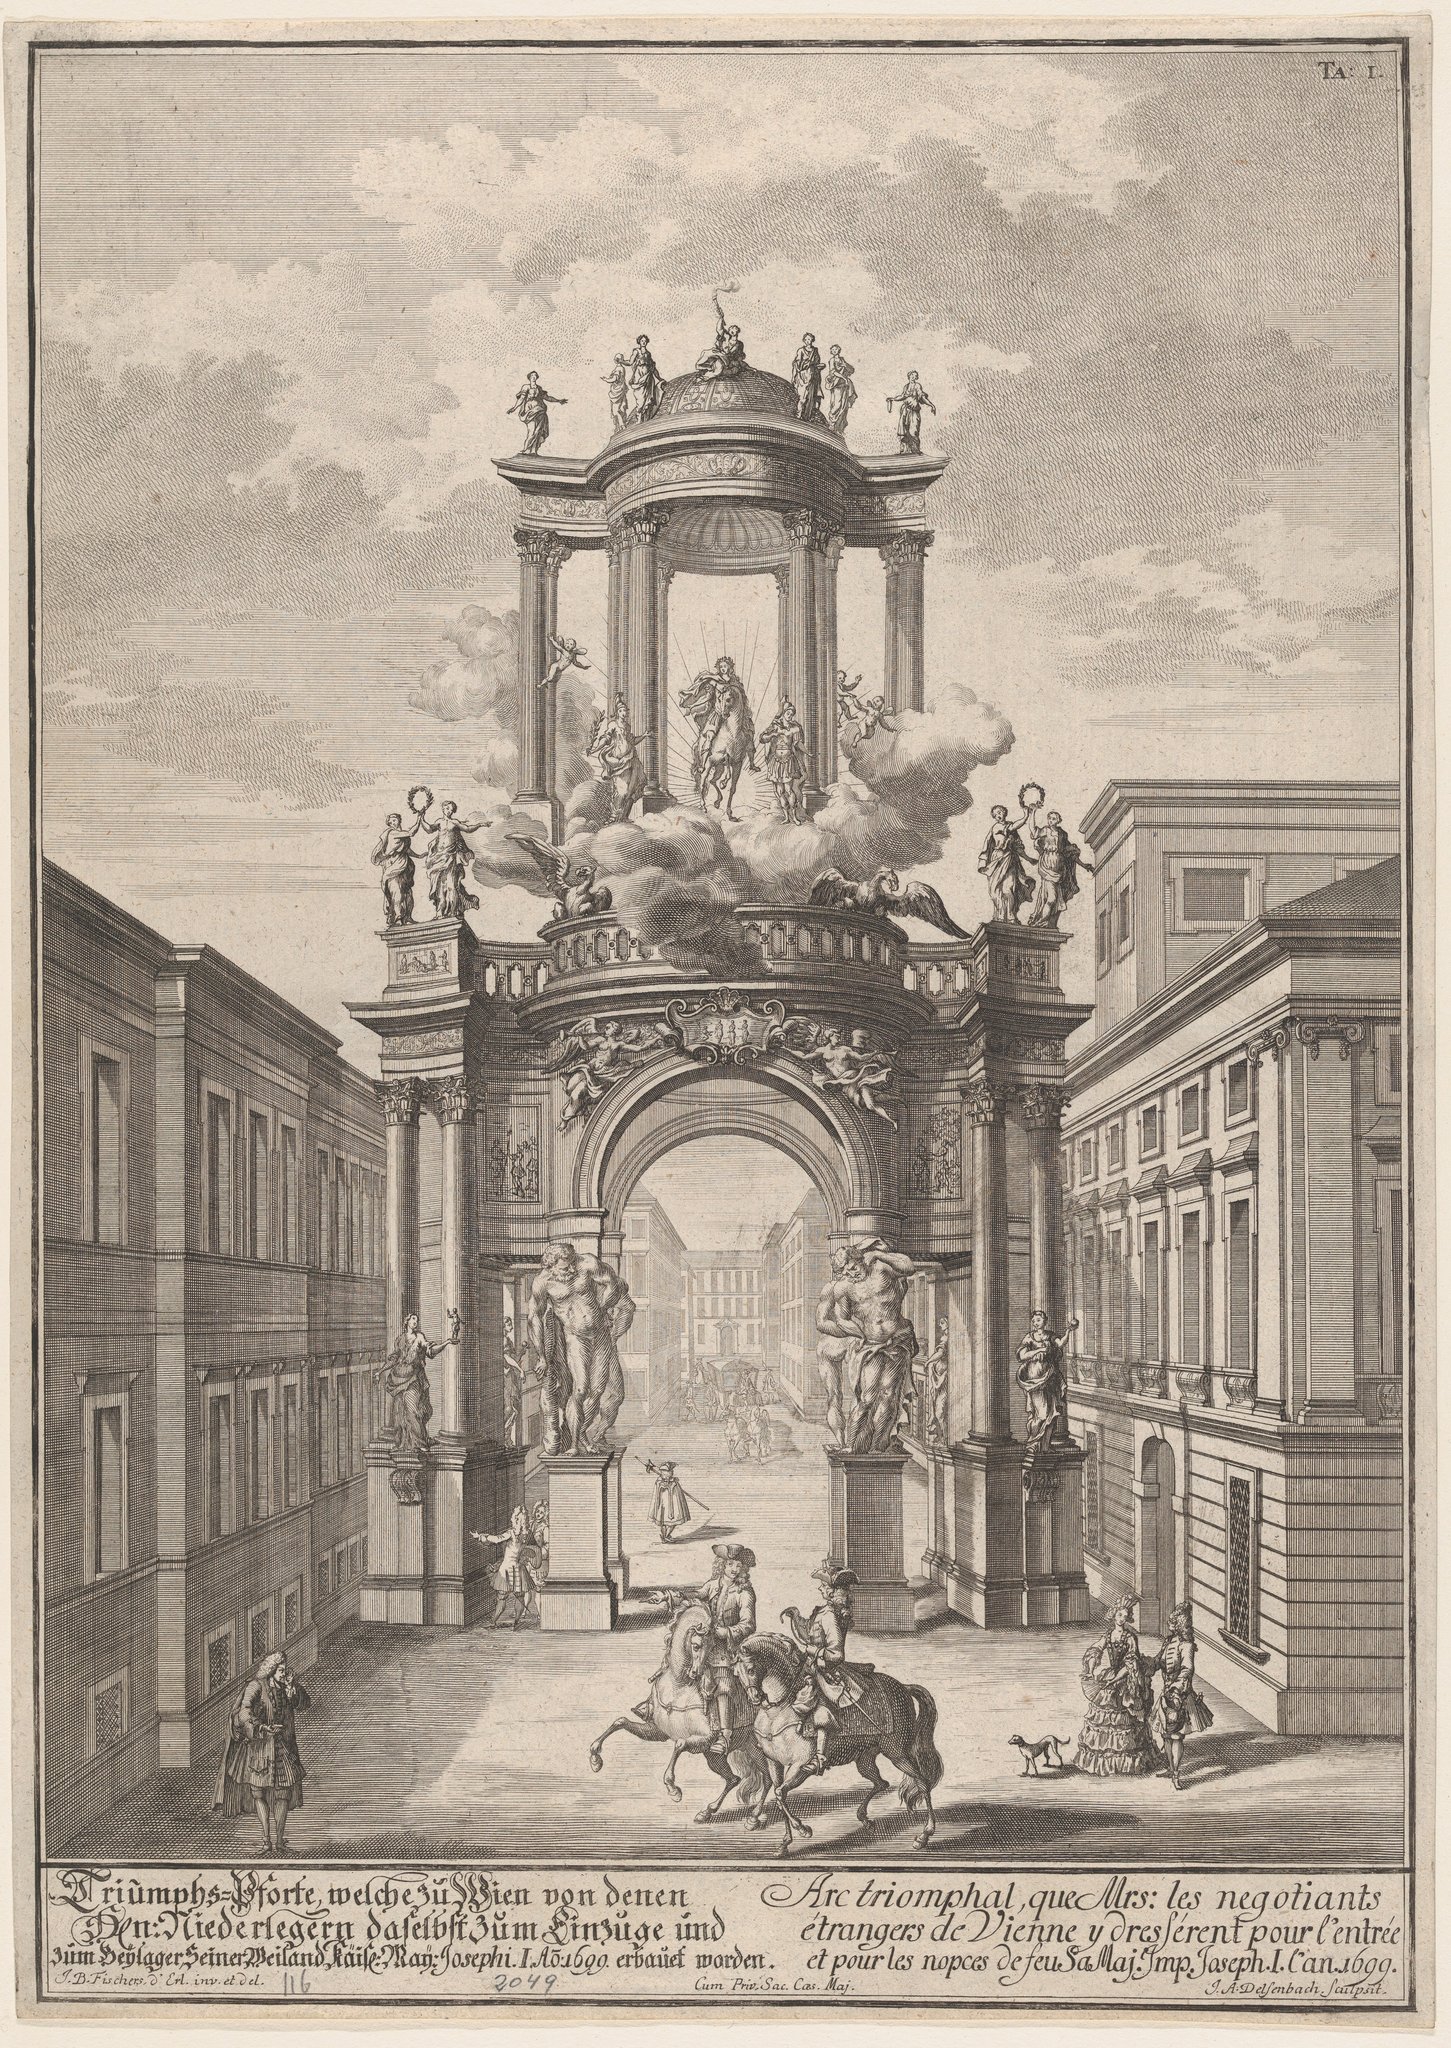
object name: print, fete, ornament architecture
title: Triumphal arch erected by the foreign merchants of Vienna for the marriage of Joseph I in 1699; from 'Entwurff einer historischen Architectur ...'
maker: johann adam delsenbach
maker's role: artist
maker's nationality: german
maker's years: 1687-1765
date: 1699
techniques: engraving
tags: architecture,arches,horses